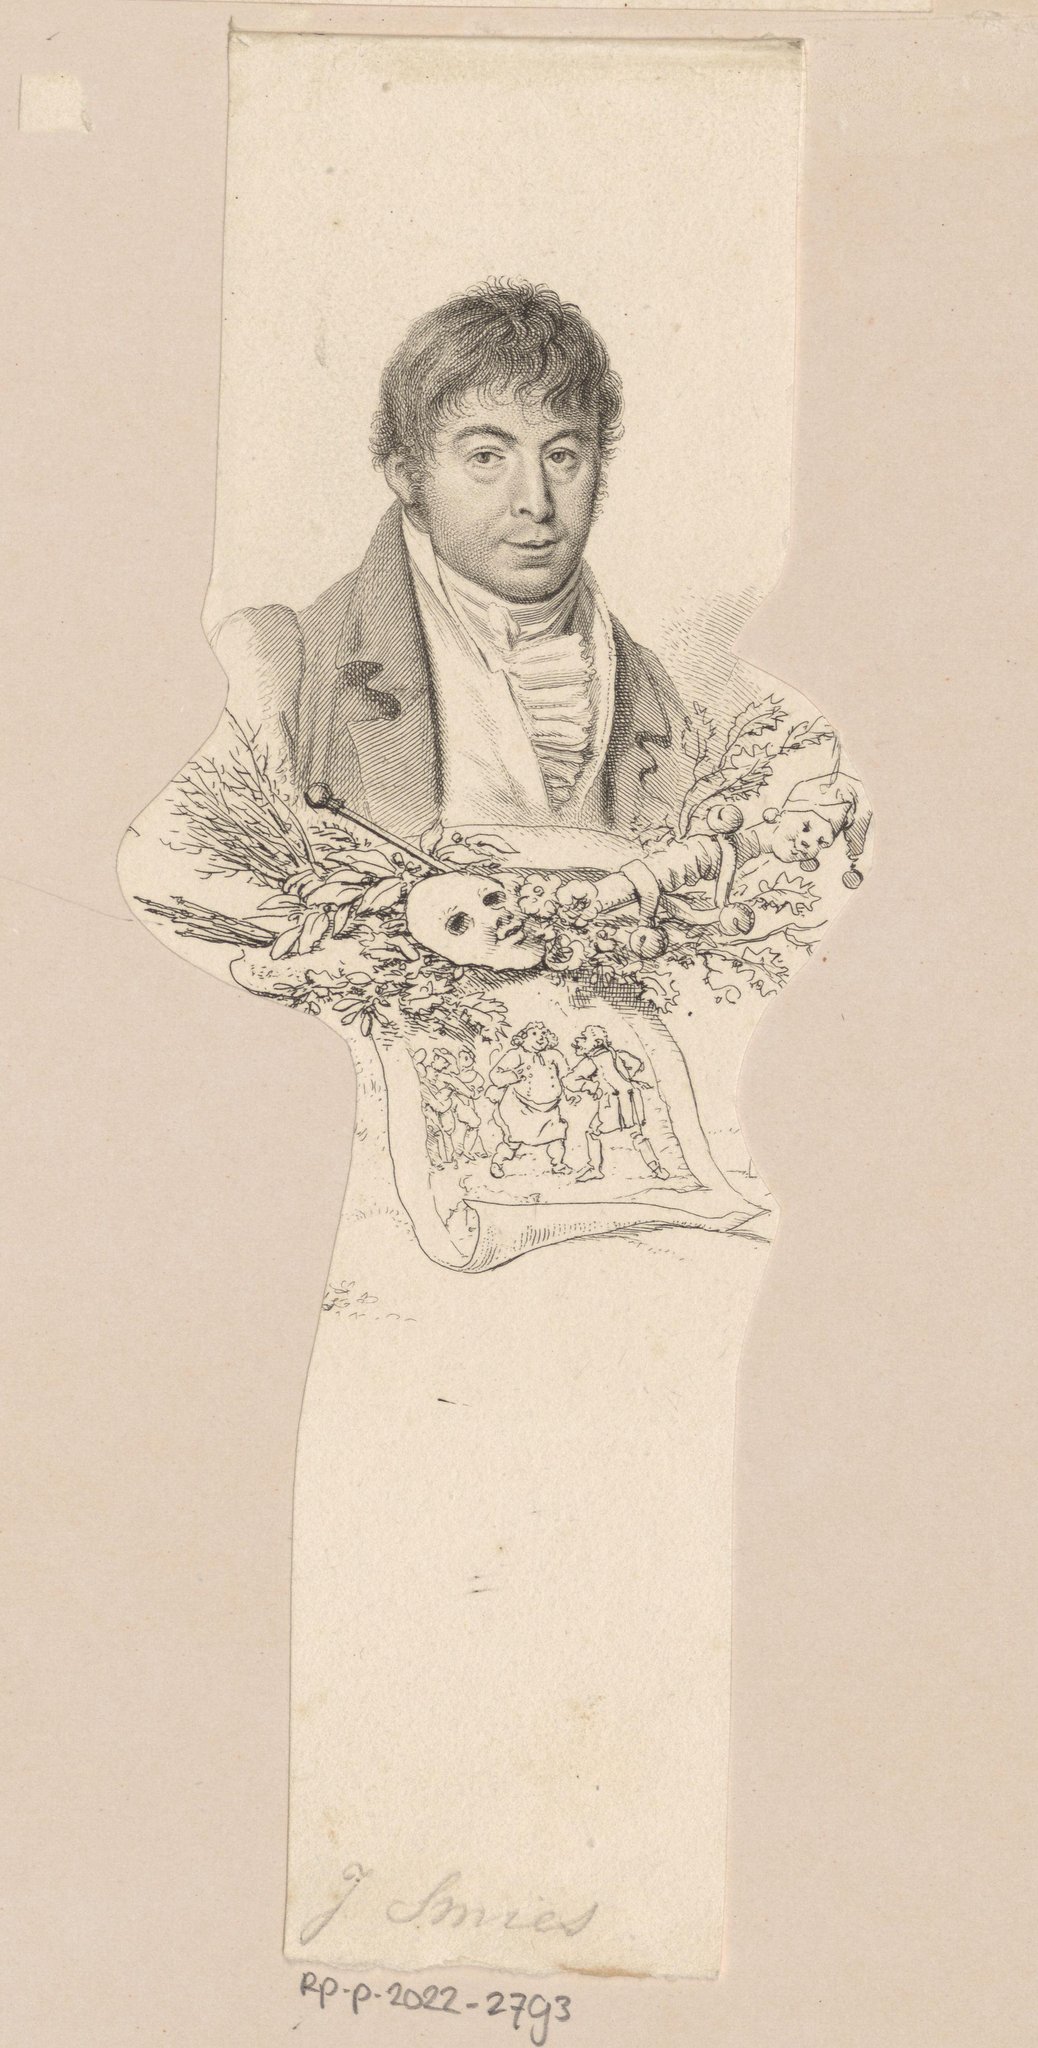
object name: print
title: Portret van Jacob Smies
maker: jacob ernst marcus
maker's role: draughtsman, print maker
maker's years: 1774-1826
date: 1811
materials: paper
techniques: etching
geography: amsterdam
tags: painter, jacob smies, historical persons, portrait, self-portrait of artist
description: Latere staat van de prent gebruikt in: Marcus, Jacob Ernst. Etudes gravées. Amsterdam: S. de Grebber, 1826.